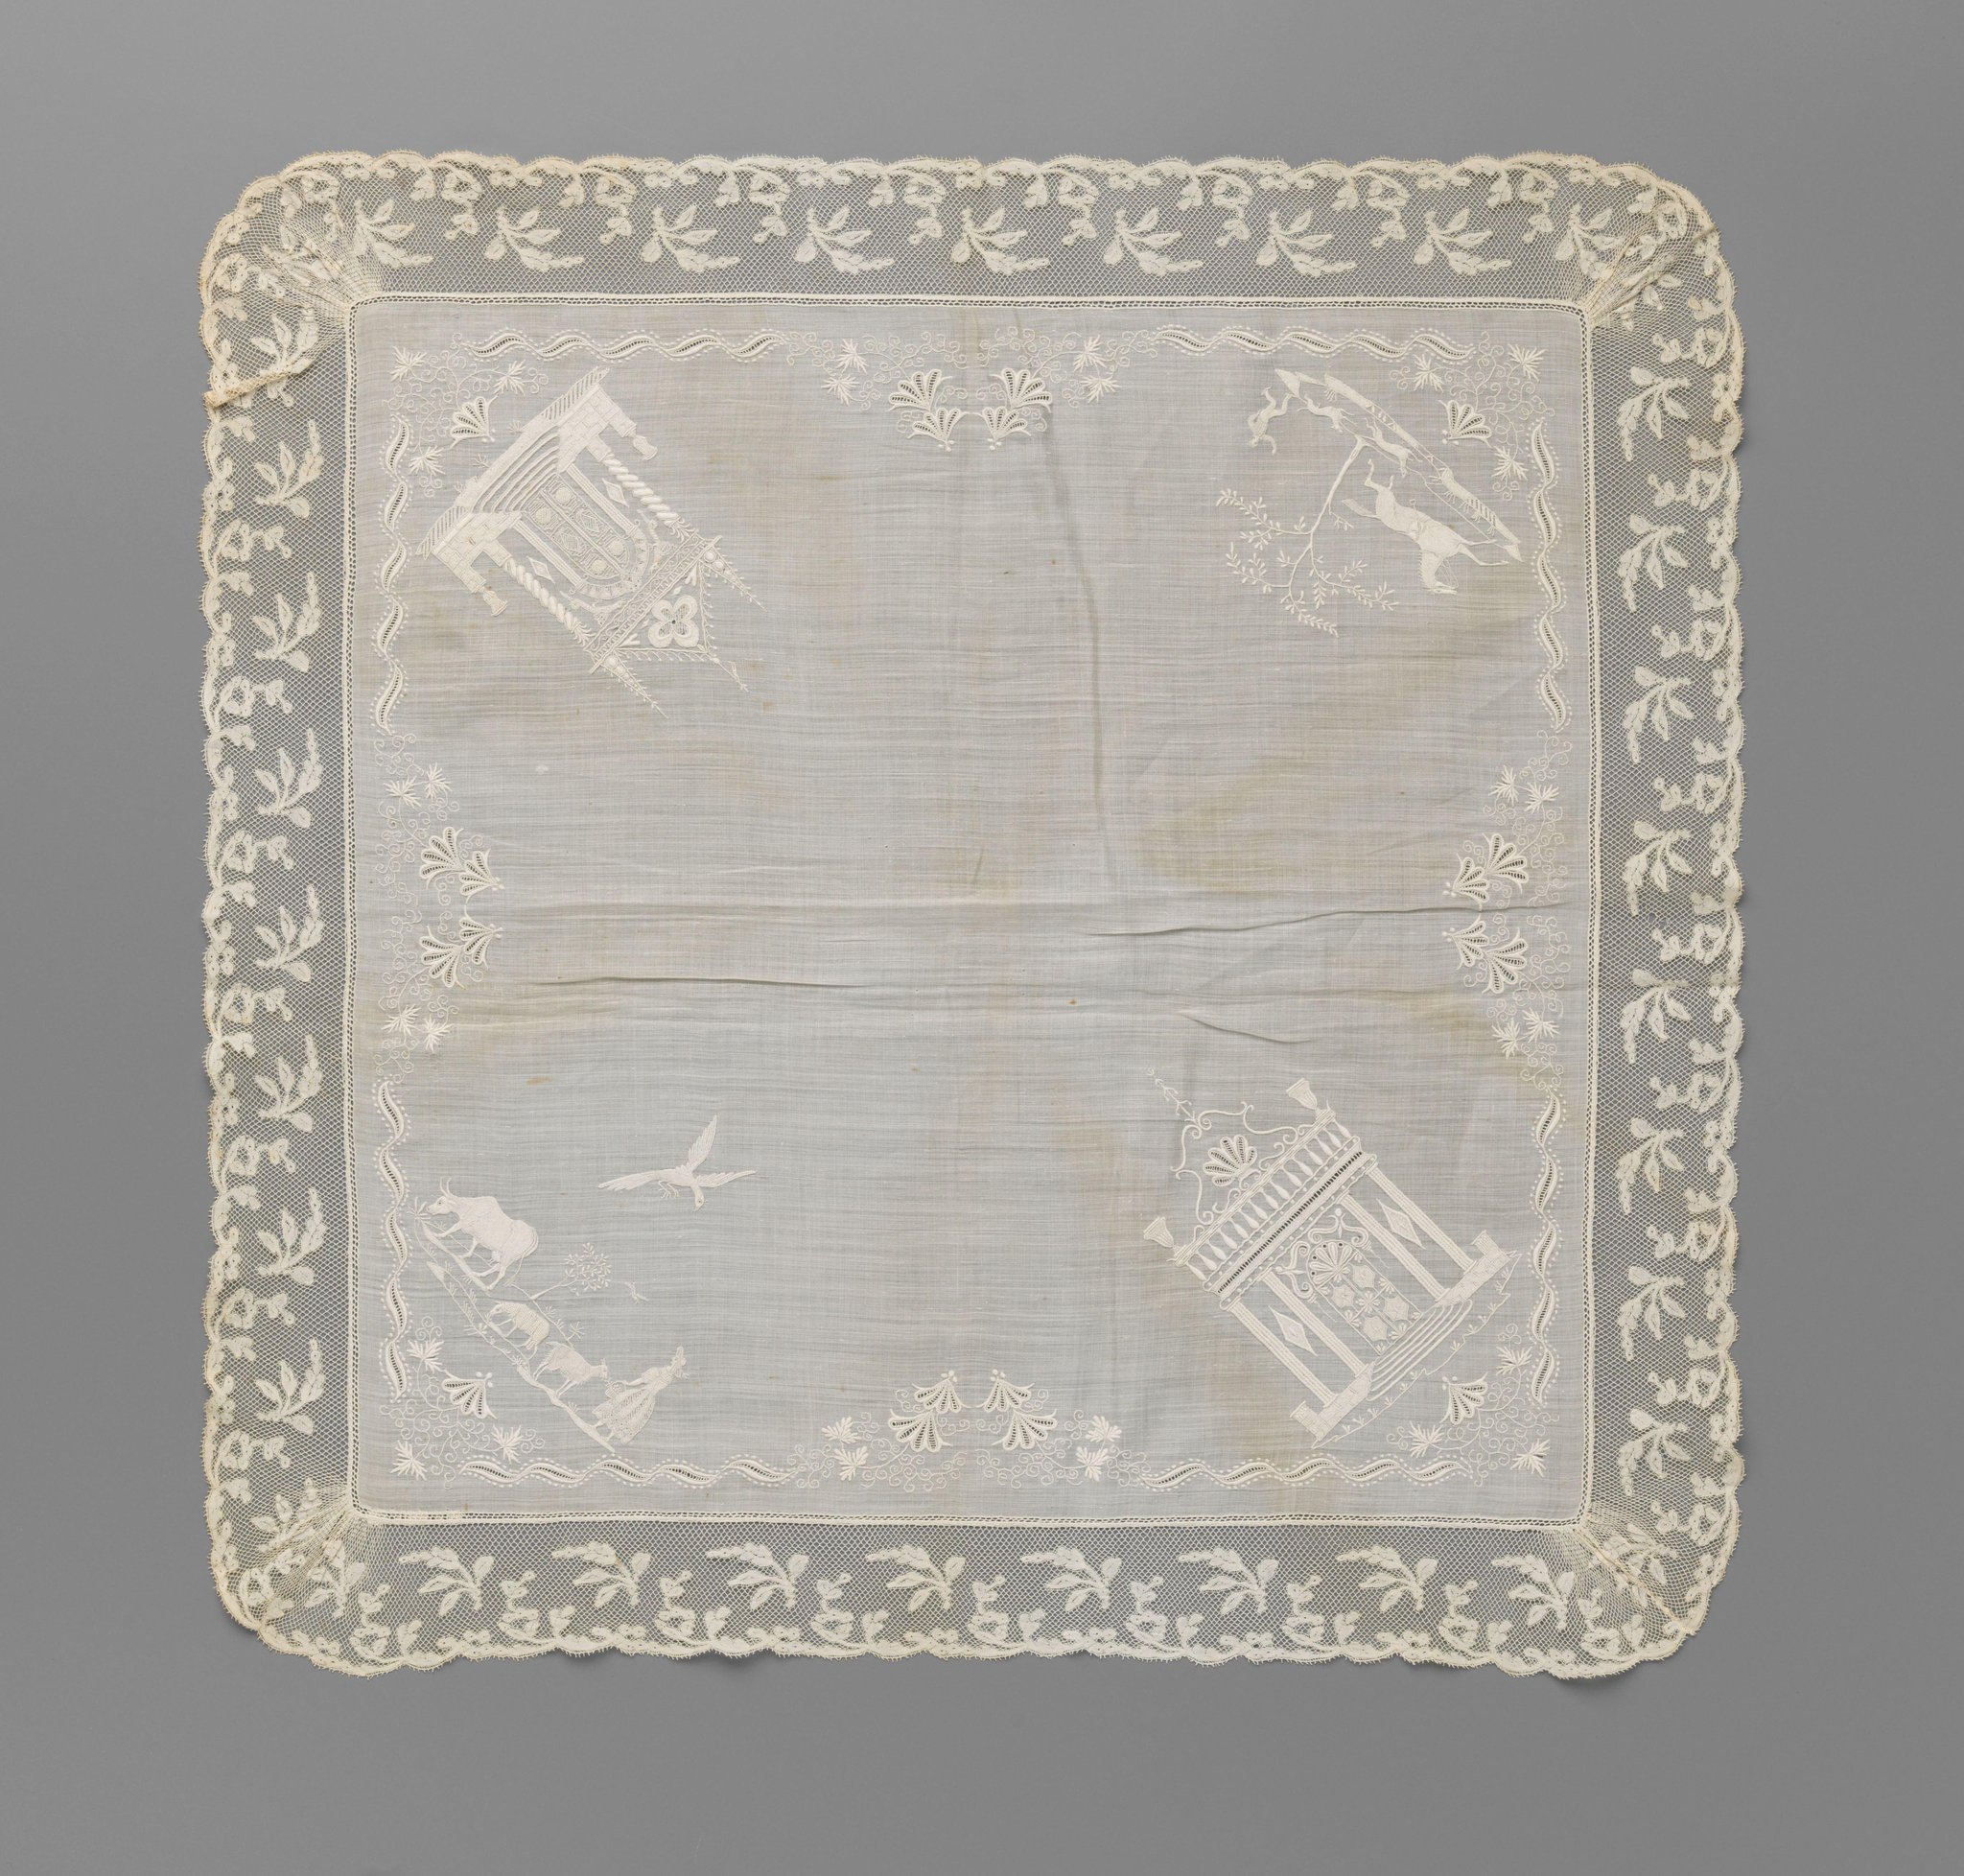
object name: womenswear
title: Zakdoek van batist waarop borduurwerk met een man die achter zijn paard aan rent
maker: Anonymous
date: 1850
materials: linen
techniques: lace, embroidered, weave, embroidery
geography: england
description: Zakdoek van naturelkleurige batist met borduurwerk - witwerk - en rondom een rand kloskant: Valenciennes-kant. Vierkant model met afgeronde hoeken door de strook kant die bij de hoeken geplooid is aangezet. Het batist is langs elke zijde in het midden geborduurd met palmetbladeren omringd door sterk krullende ijle ranken en aan beide zijden geflankeerd door een langerekt golvend lint. In elk van twee tegenover elkaar liggende hoeken is een vergelijkbaar gebouwtje geborduurd: een gloriette met pilaren, een trap en hoge deuren. In de andere twee hoeken zijn tafereeltjes geborduurd met mensen, dieren en bomen. In de ene hoek vliegt een papegaai. De vogel kijkt naar een herderin met haar koe, schaap en geit. In de andere hoek rent een man met zijn twee honden achter een gezadeld paard aan. Hij houdt één hand op zijn billen. De rand kloskant heeft een zich herhalend patroon dat bestaat uit een pluimbloem aan een steel met drie bladeren. Langs de onderzijde ligt een aaneenschakeling van drie verschillende soorten bloemen, waarvan de gebogen stelen de schulpenrand vormen. De motieven zijn gemaakt in linnenslag met opengewerkte randjes en fijne uitsparingen. Ze zijn met elkaar verbonden door een traliegrond: een vierkante Valenciennes-grond. De schulpenrand is afgewerkt met picots.